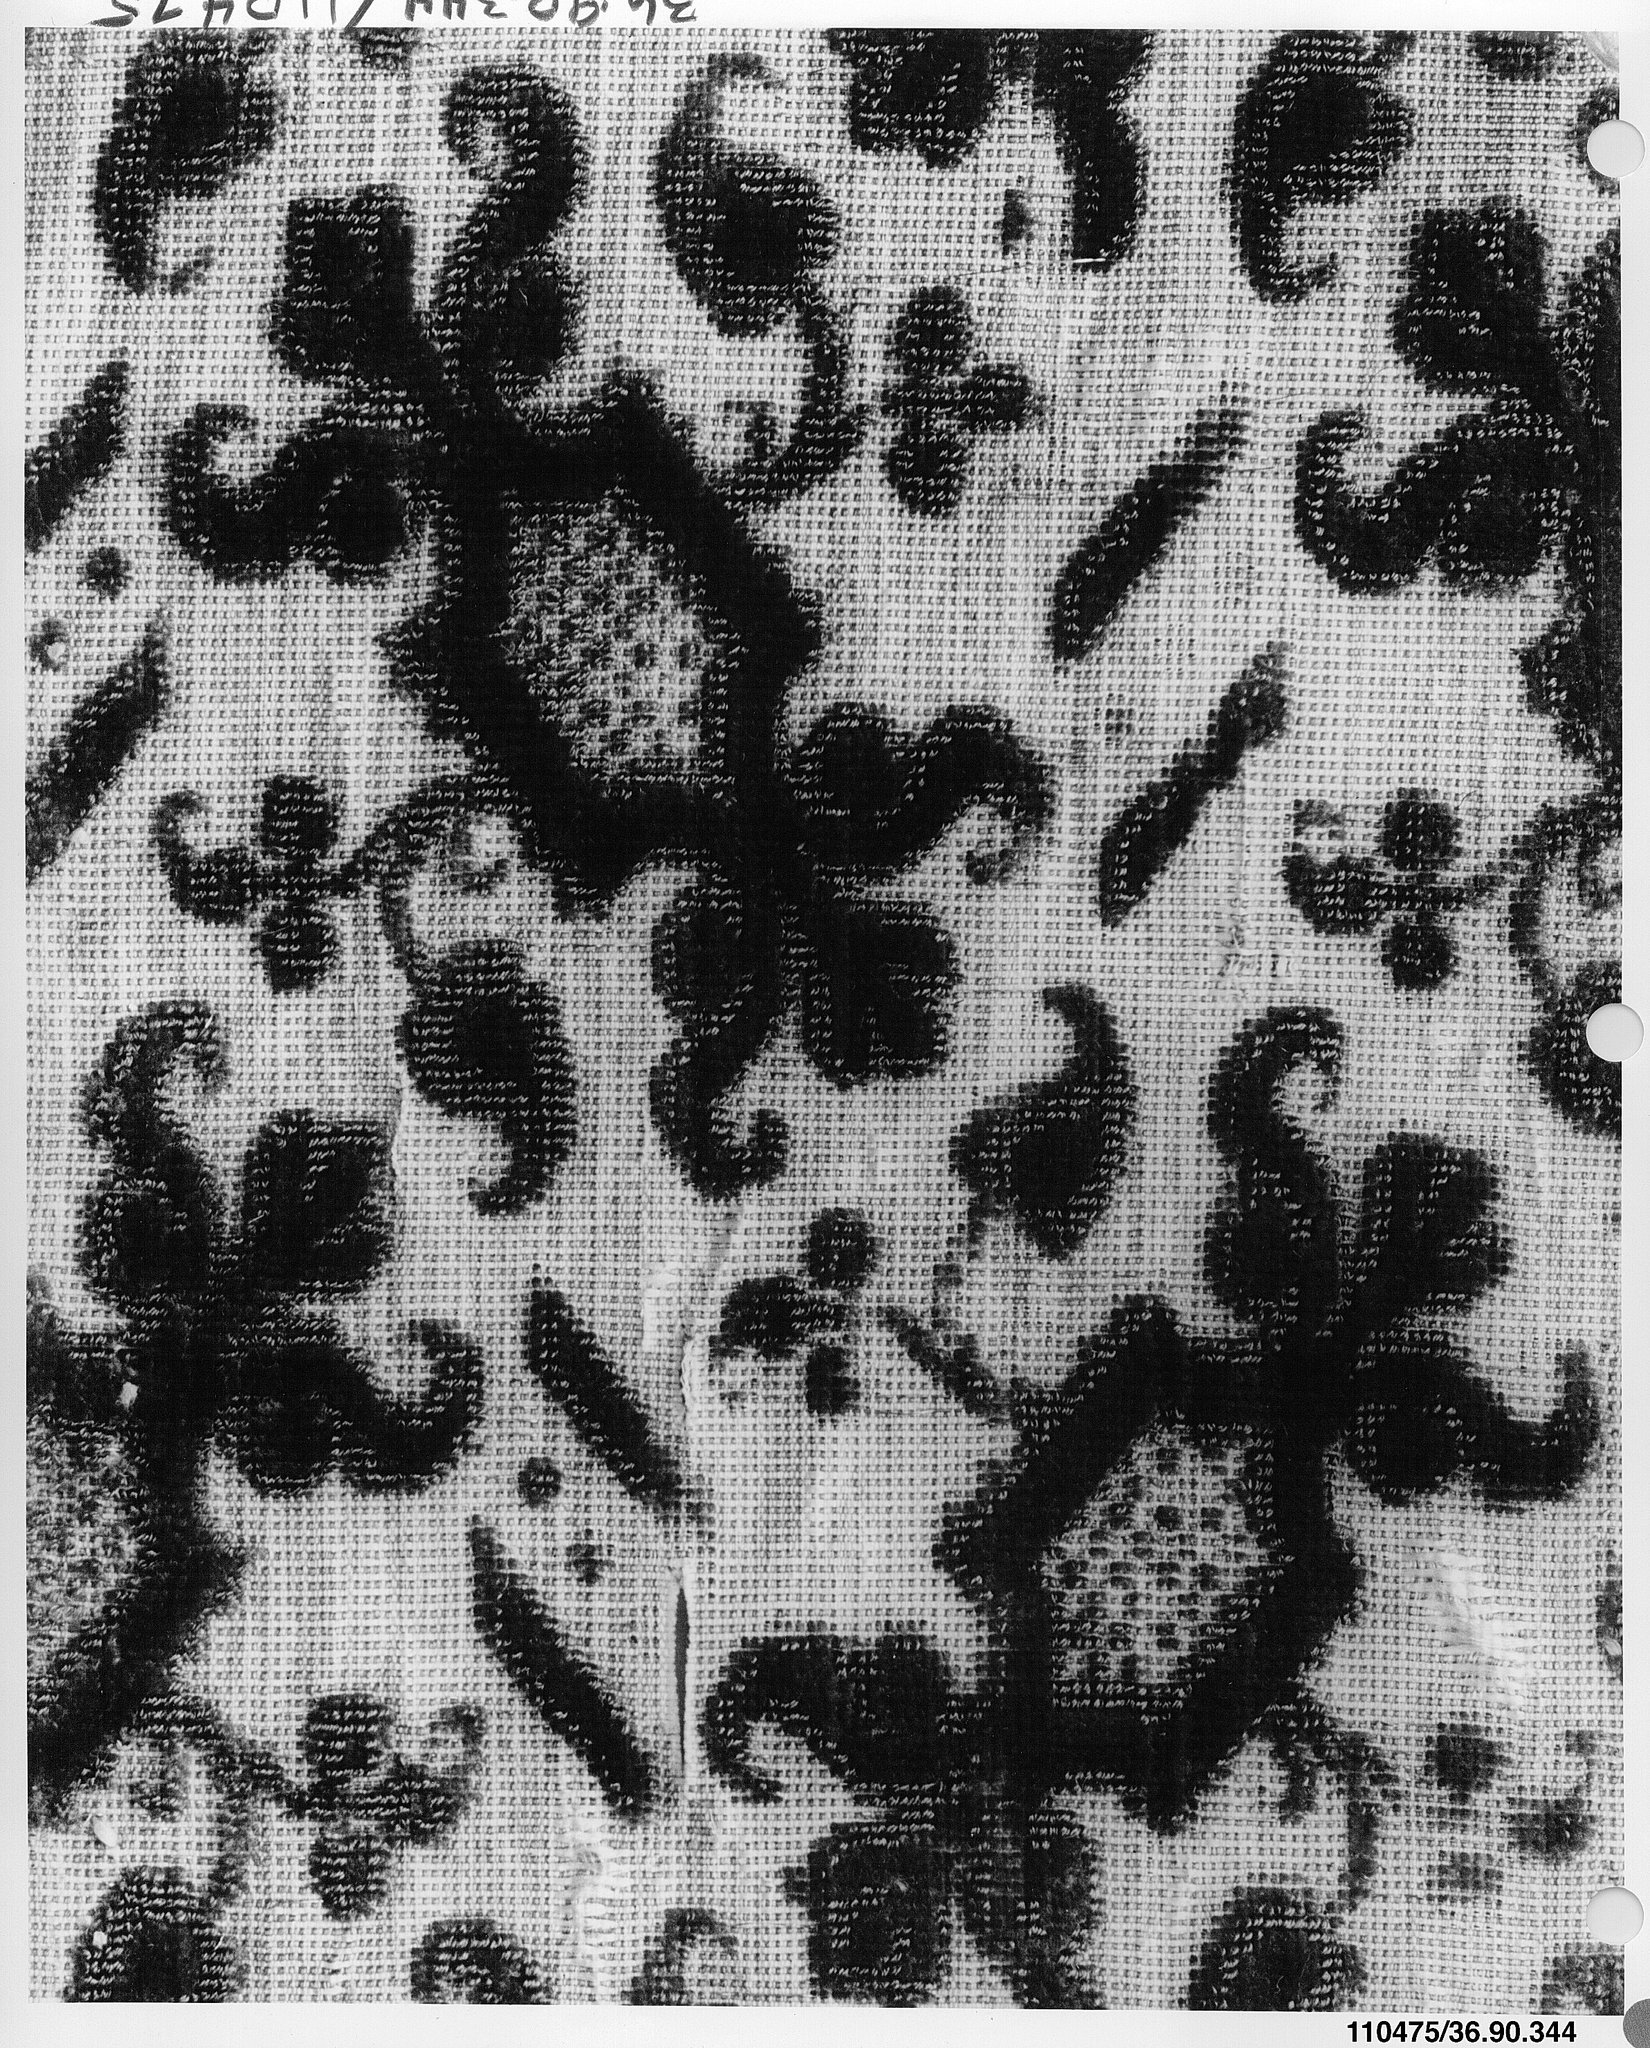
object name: piece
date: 1501-1700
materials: metal thread, silk